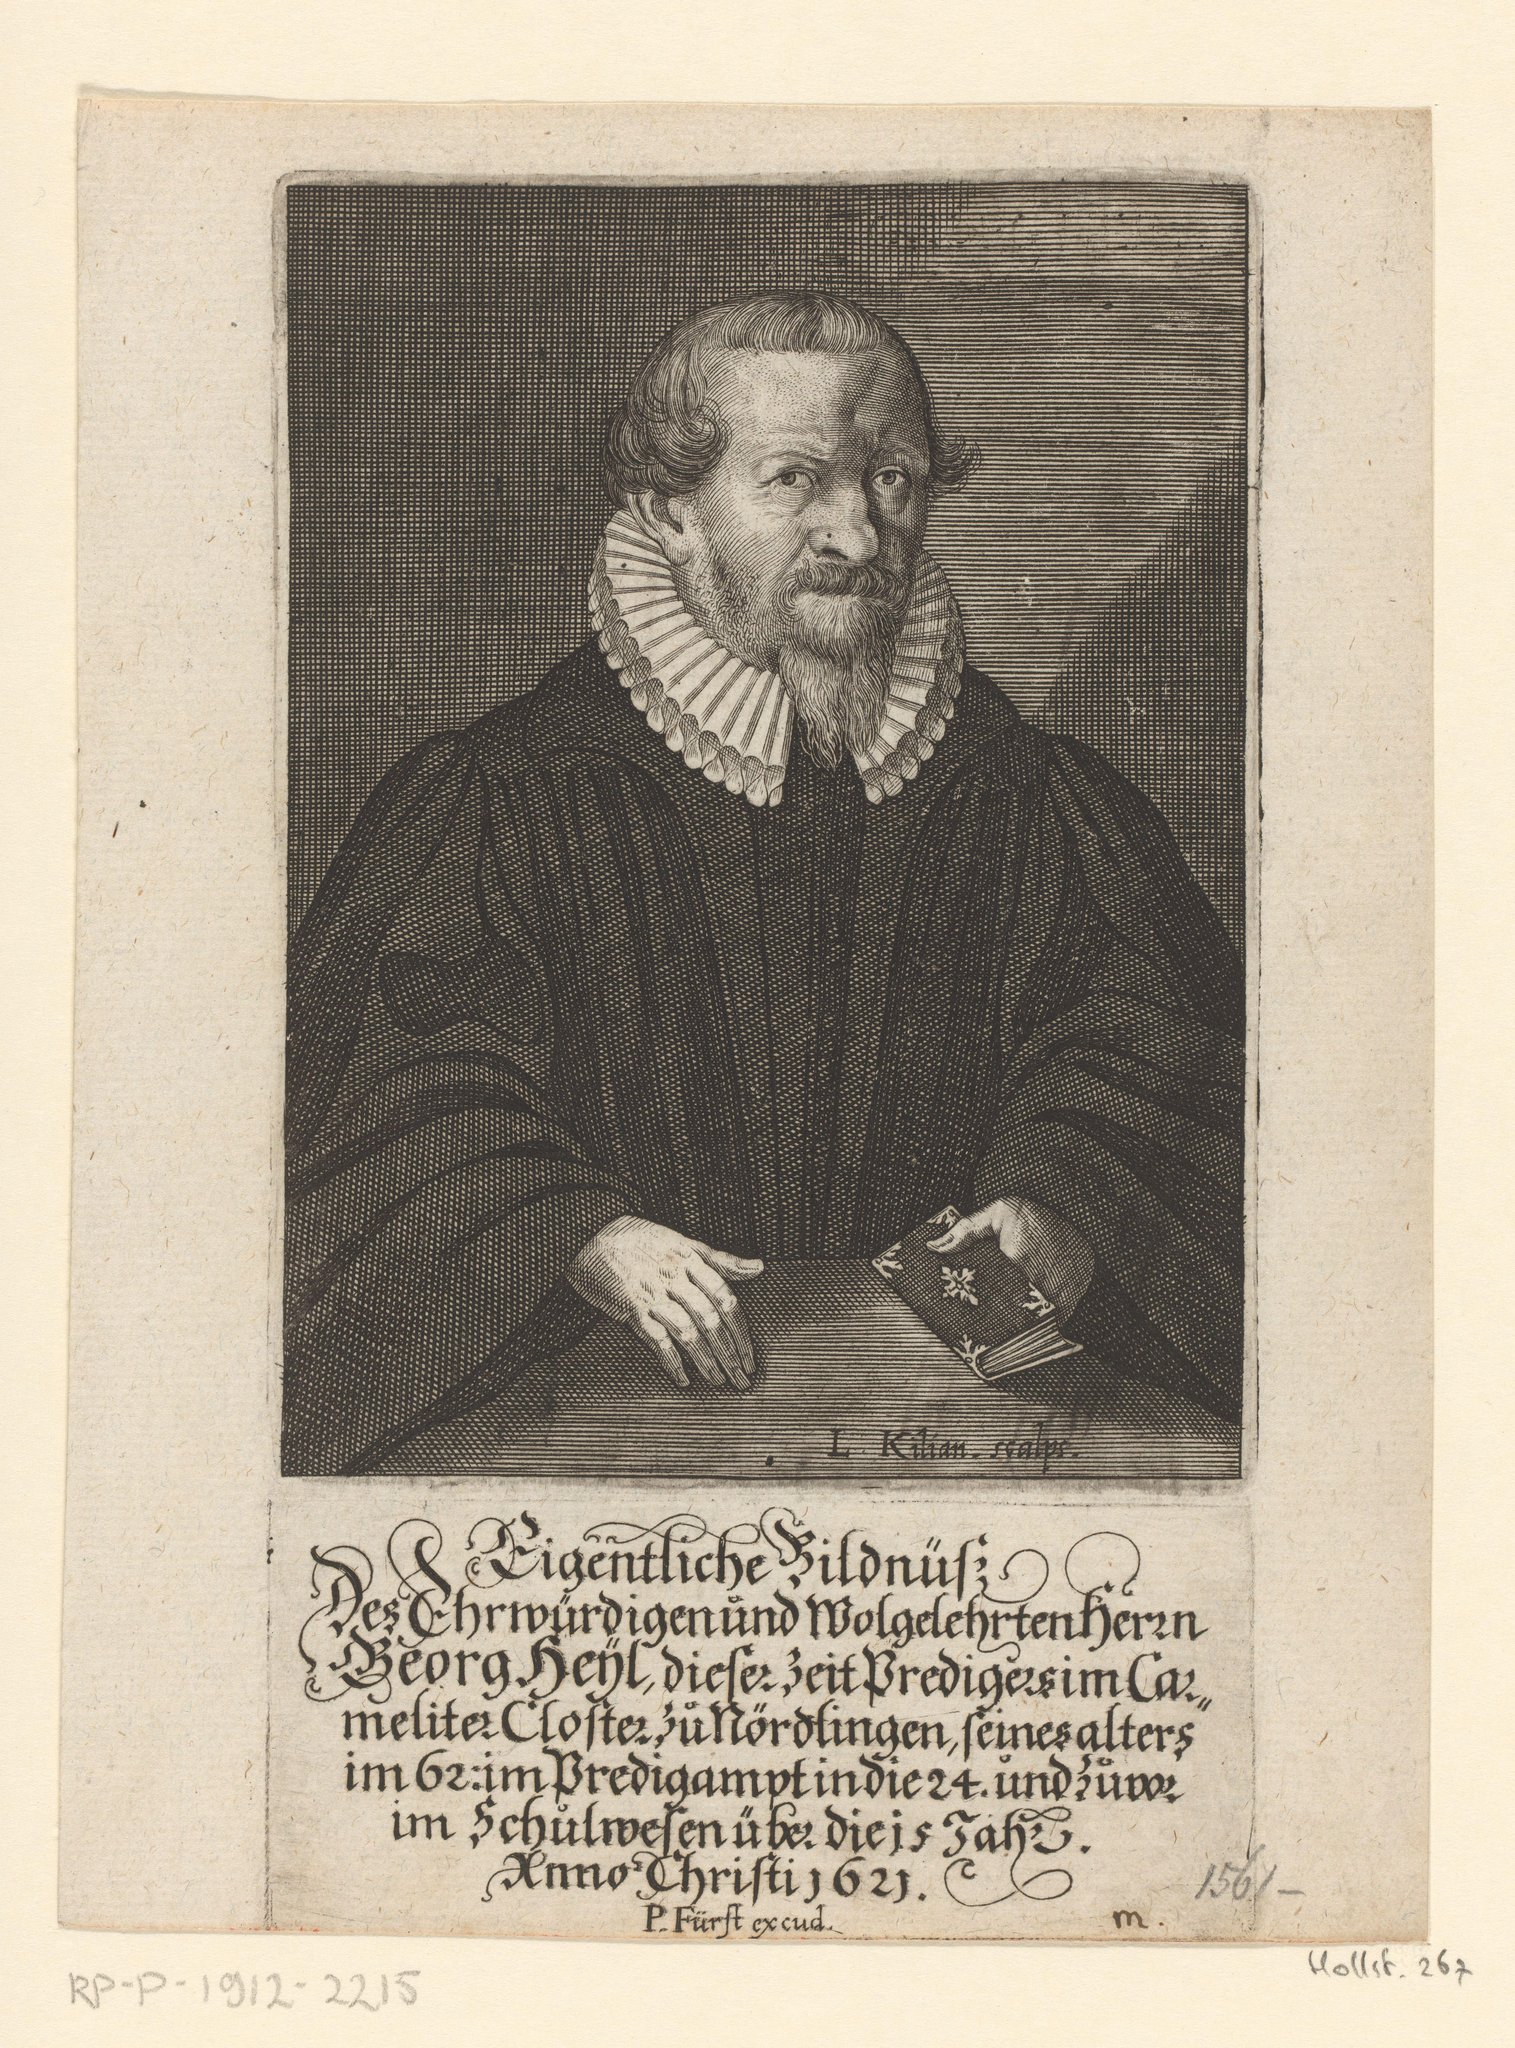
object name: print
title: Portret van Georg Heijl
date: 1621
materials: paper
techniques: engraving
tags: theologian, historical persons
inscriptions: collector's mark: Lugt 2228